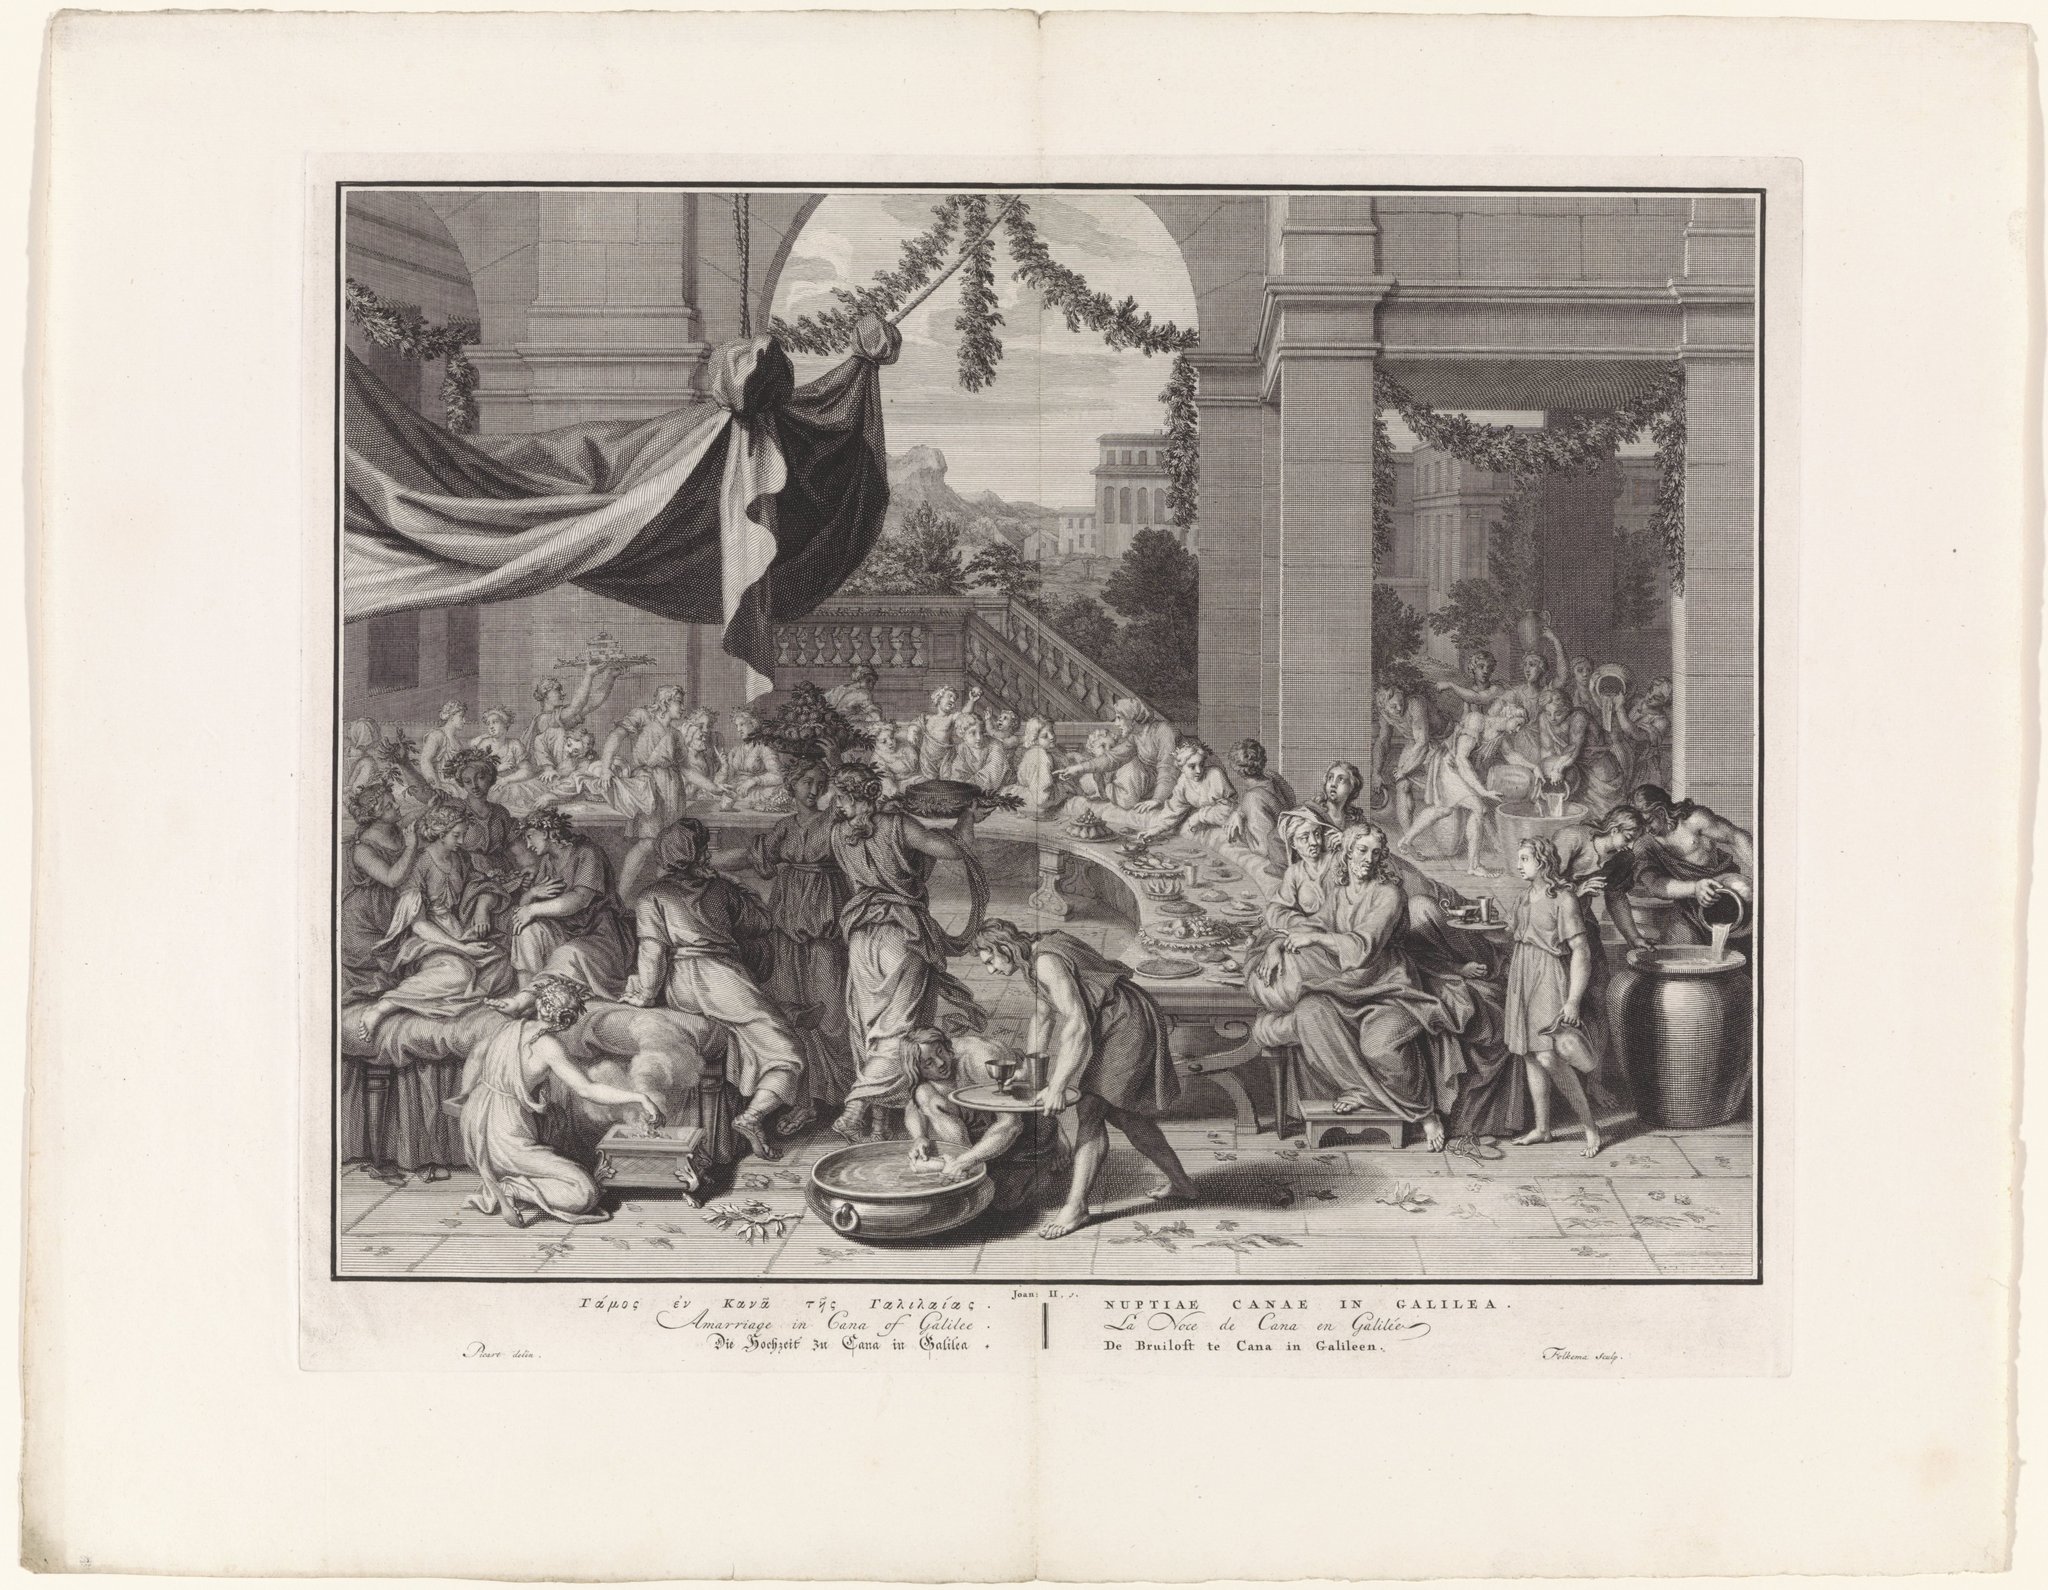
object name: book illustration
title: Bruiloft te Kana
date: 1720-1728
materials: paper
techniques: engraving, etching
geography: amsterdam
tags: the marriage-feast at cana (john 2:1-11)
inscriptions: inscription: ‘Utrechts Fundatie huijs’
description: Prent oorspronkelijk bedoeld voor: Figures de la Bible. Amsterdam: Bernard Picart, 1720. Prent ook gebruikt in: Taferelen der voornaamste geschiedenissen van het Oude en Nieuwe Testament (...) door de vermaarde kunstenaars Hoet, Houbraken, en Picart getekent (...) en met beschrijvingen uitgebreid. Den Haag: Pieter de Hondt, 1728.